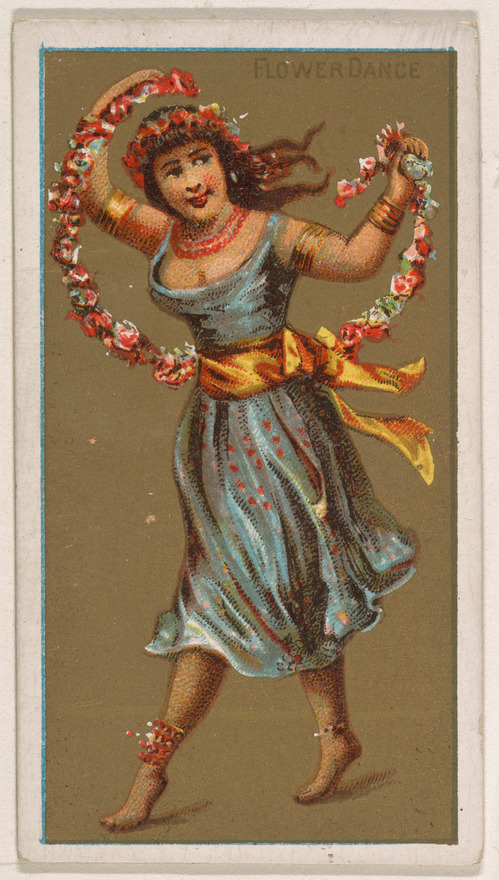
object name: print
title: Flower Dance, from National Dances (N225, Type 1) issued by Kinney Bros.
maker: kinney brothers tobacco company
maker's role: publisher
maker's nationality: american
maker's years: 1869-2011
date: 1889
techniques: color lithograph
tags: garlands,women,dancing